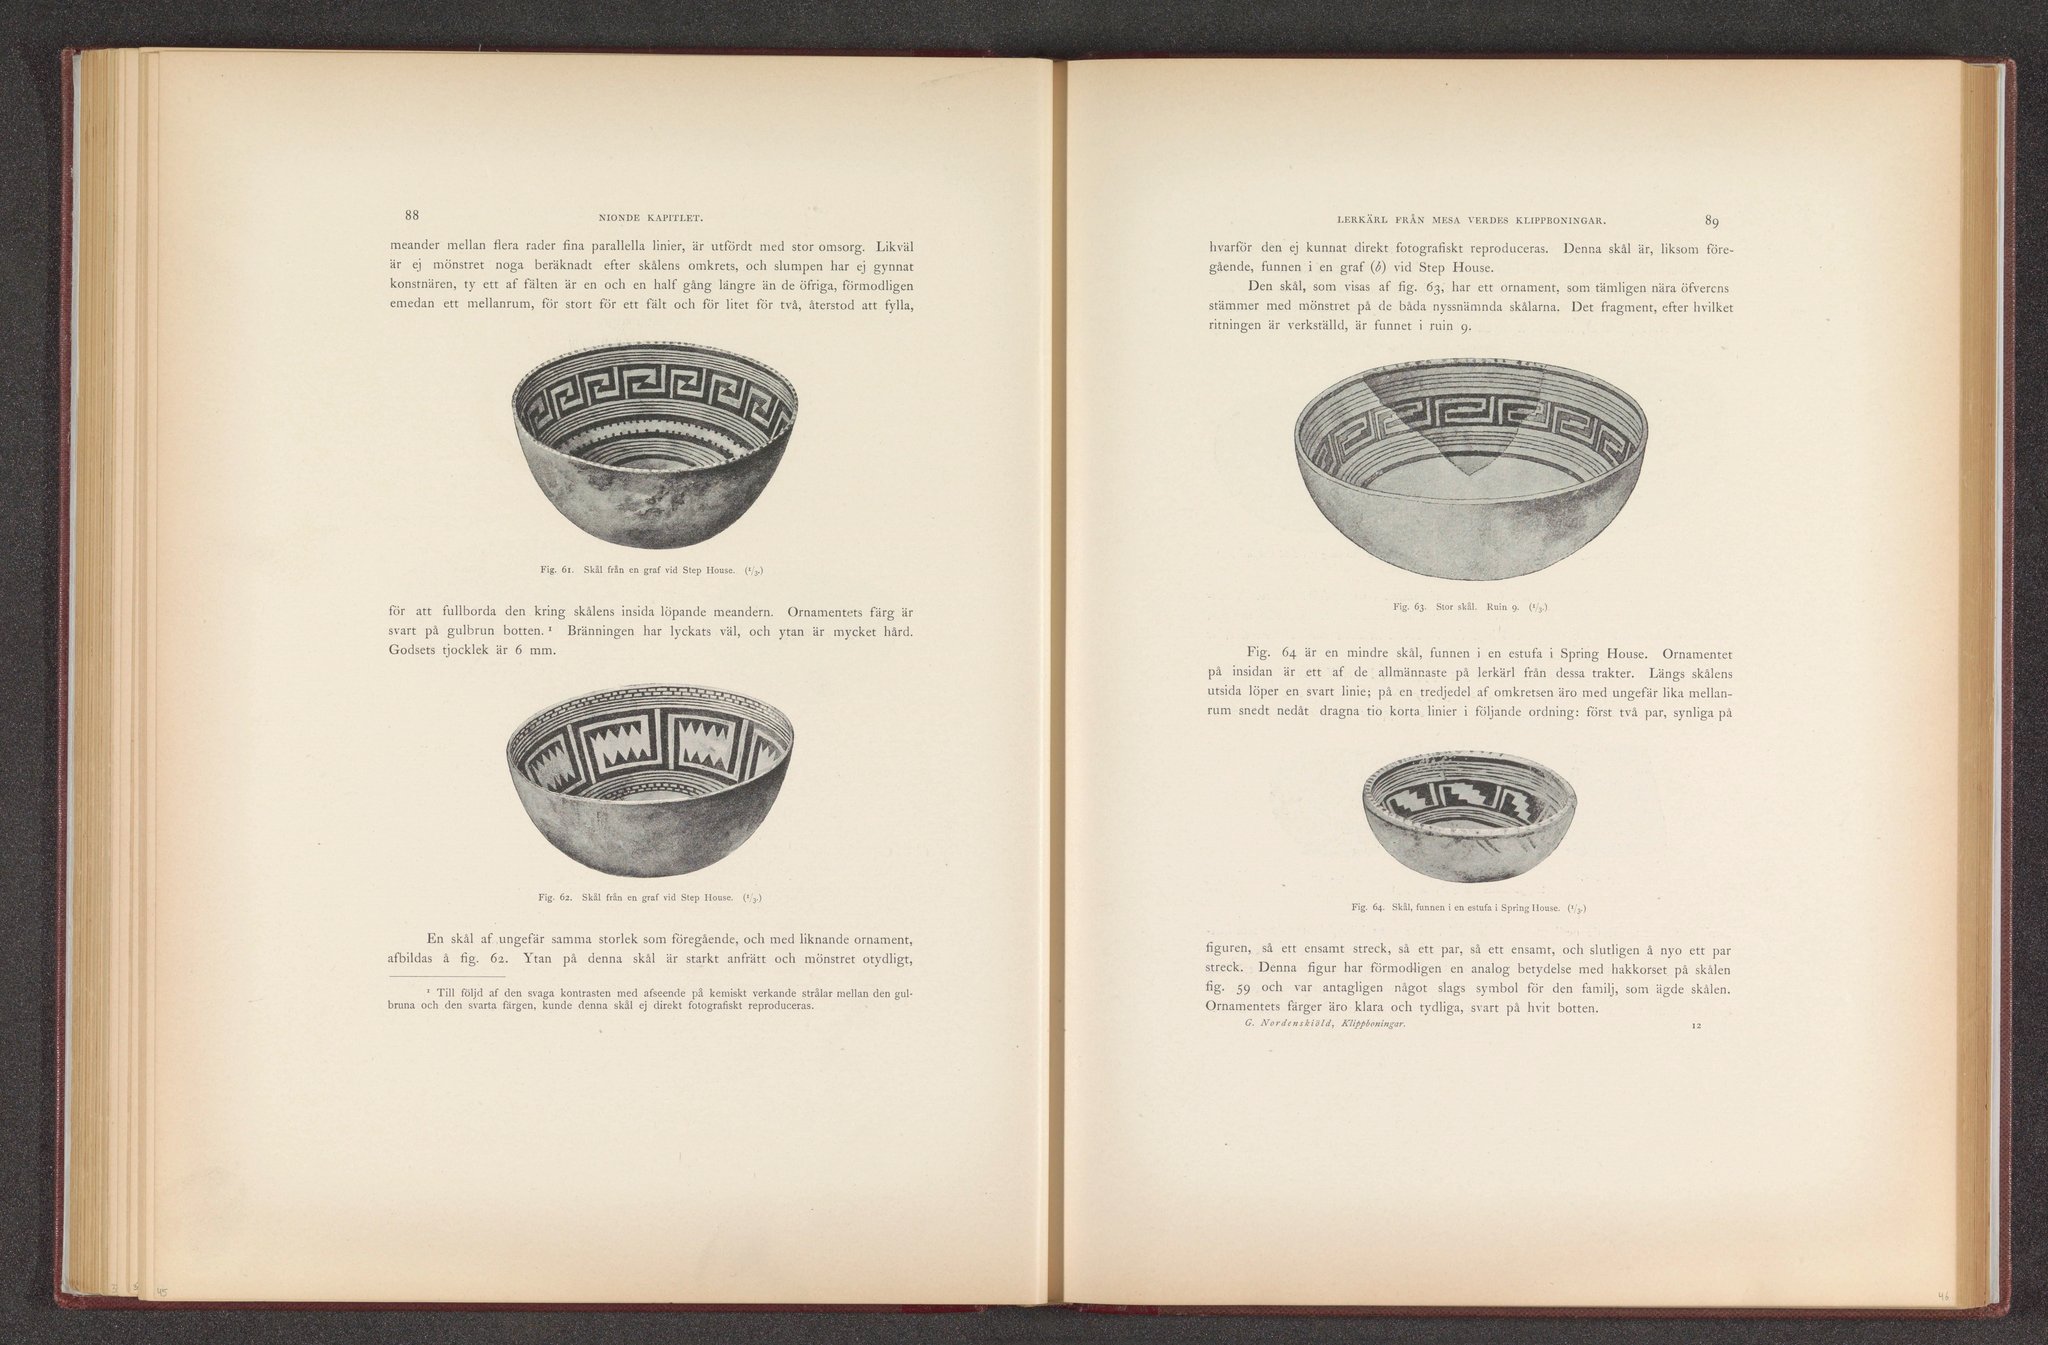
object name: page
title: Stor skål. Ruin 9. Skål, funnen i en estufa i Sping House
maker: gustaf nordenskiöld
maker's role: fotograaf, schrijver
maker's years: 1868-1895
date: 1891-1893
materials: paper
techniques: autotype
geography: mesa verde national park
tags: dish, plate, saucer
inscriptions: number: ‘Fig. 63. Fig. 64.’